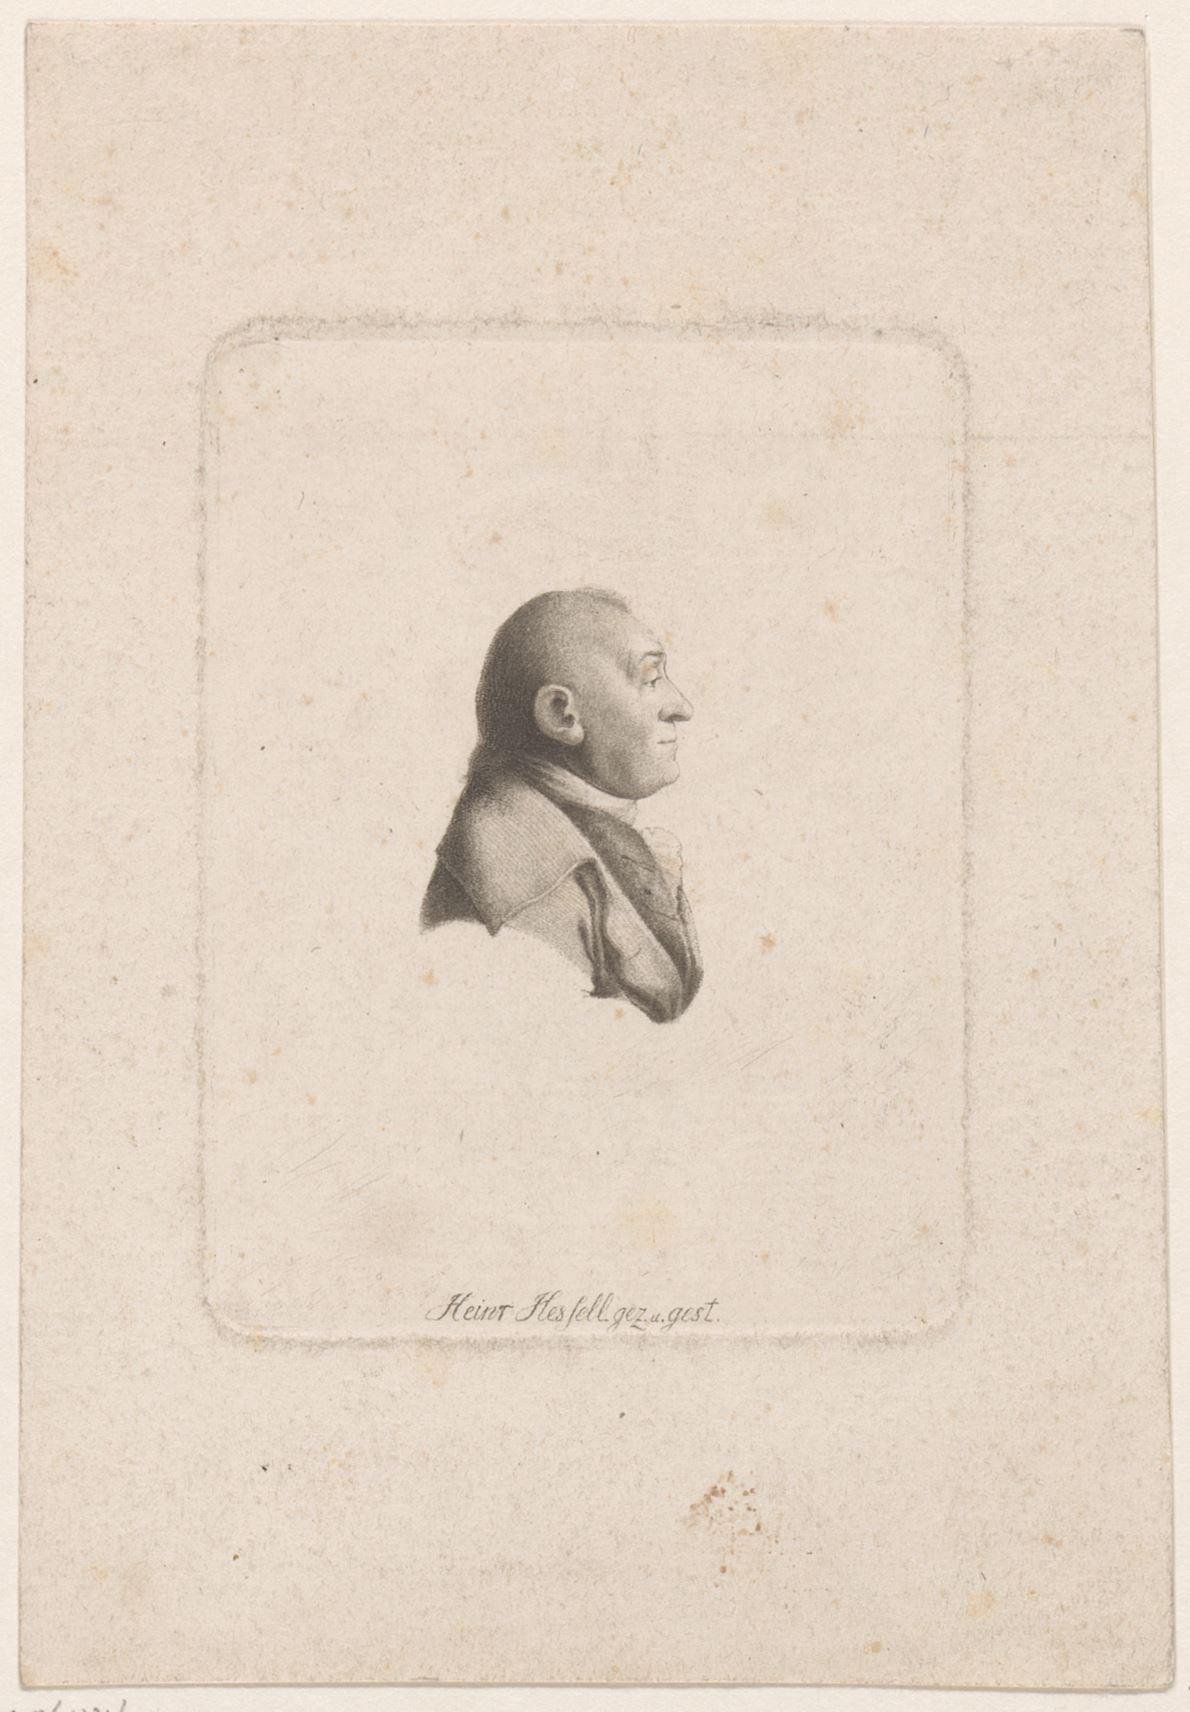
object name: print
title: Portret van Carl Egon zu Fürstenberg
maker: leonhard heinrich hessell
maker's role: musical instrument maker, painter, print maker, publisher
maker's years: 1757-1830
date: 1767-1850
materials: paper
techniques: aquatint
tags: historical persons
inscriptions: collector's mark: Lugt 2228